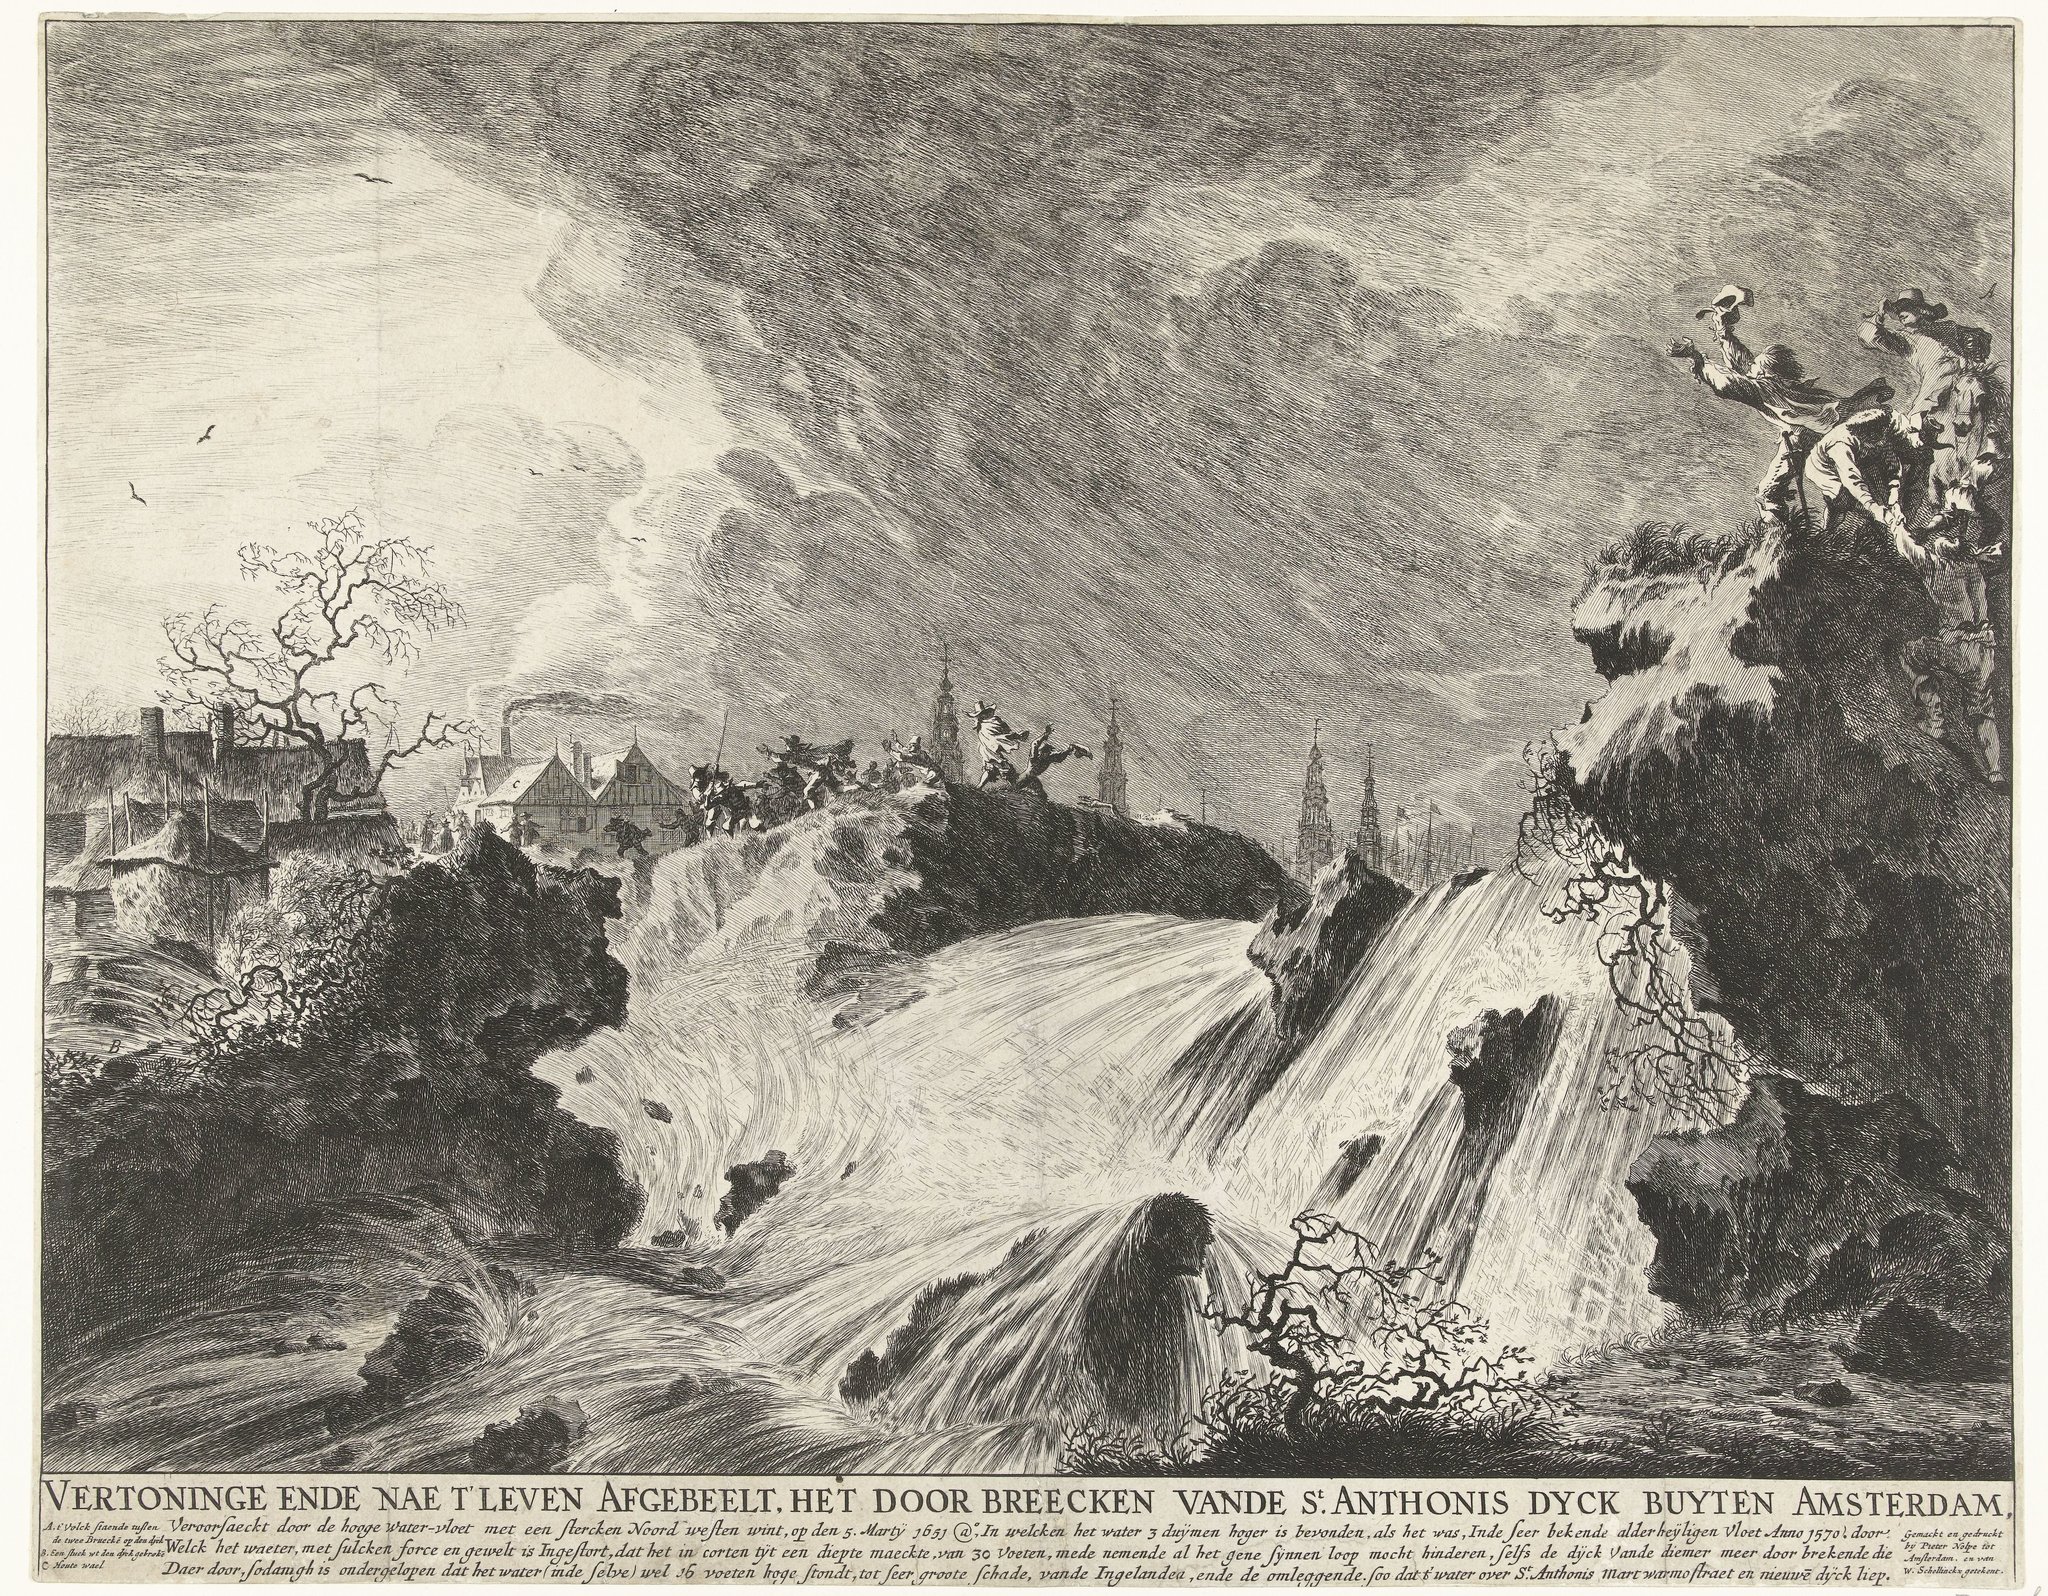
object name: print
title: Vertoninge ende nae t' leven Afgebeelt, het door breecken vande St. Anthonis dyck buyten Amsterdam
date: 1651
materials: paper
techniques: engraving, etching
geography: northern netherlands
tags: dike-break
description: Dijkdoorbraak van de Sint-Antoniesdijk of Diemerzeedijk buiten Amsterdam op 5 maart 1651, veroorzaakt door de hoge watervloed en de sterke noordwester storm. Het water stroomt door het gat in de dijk, aan weerszijden van het gat toeschouwers in paniek. Op de achtergrond de torens van Amsterdam. Linksonder het eerste deel van de legenda A-C. Zie de bijbehorende plaat (FMH 2020).